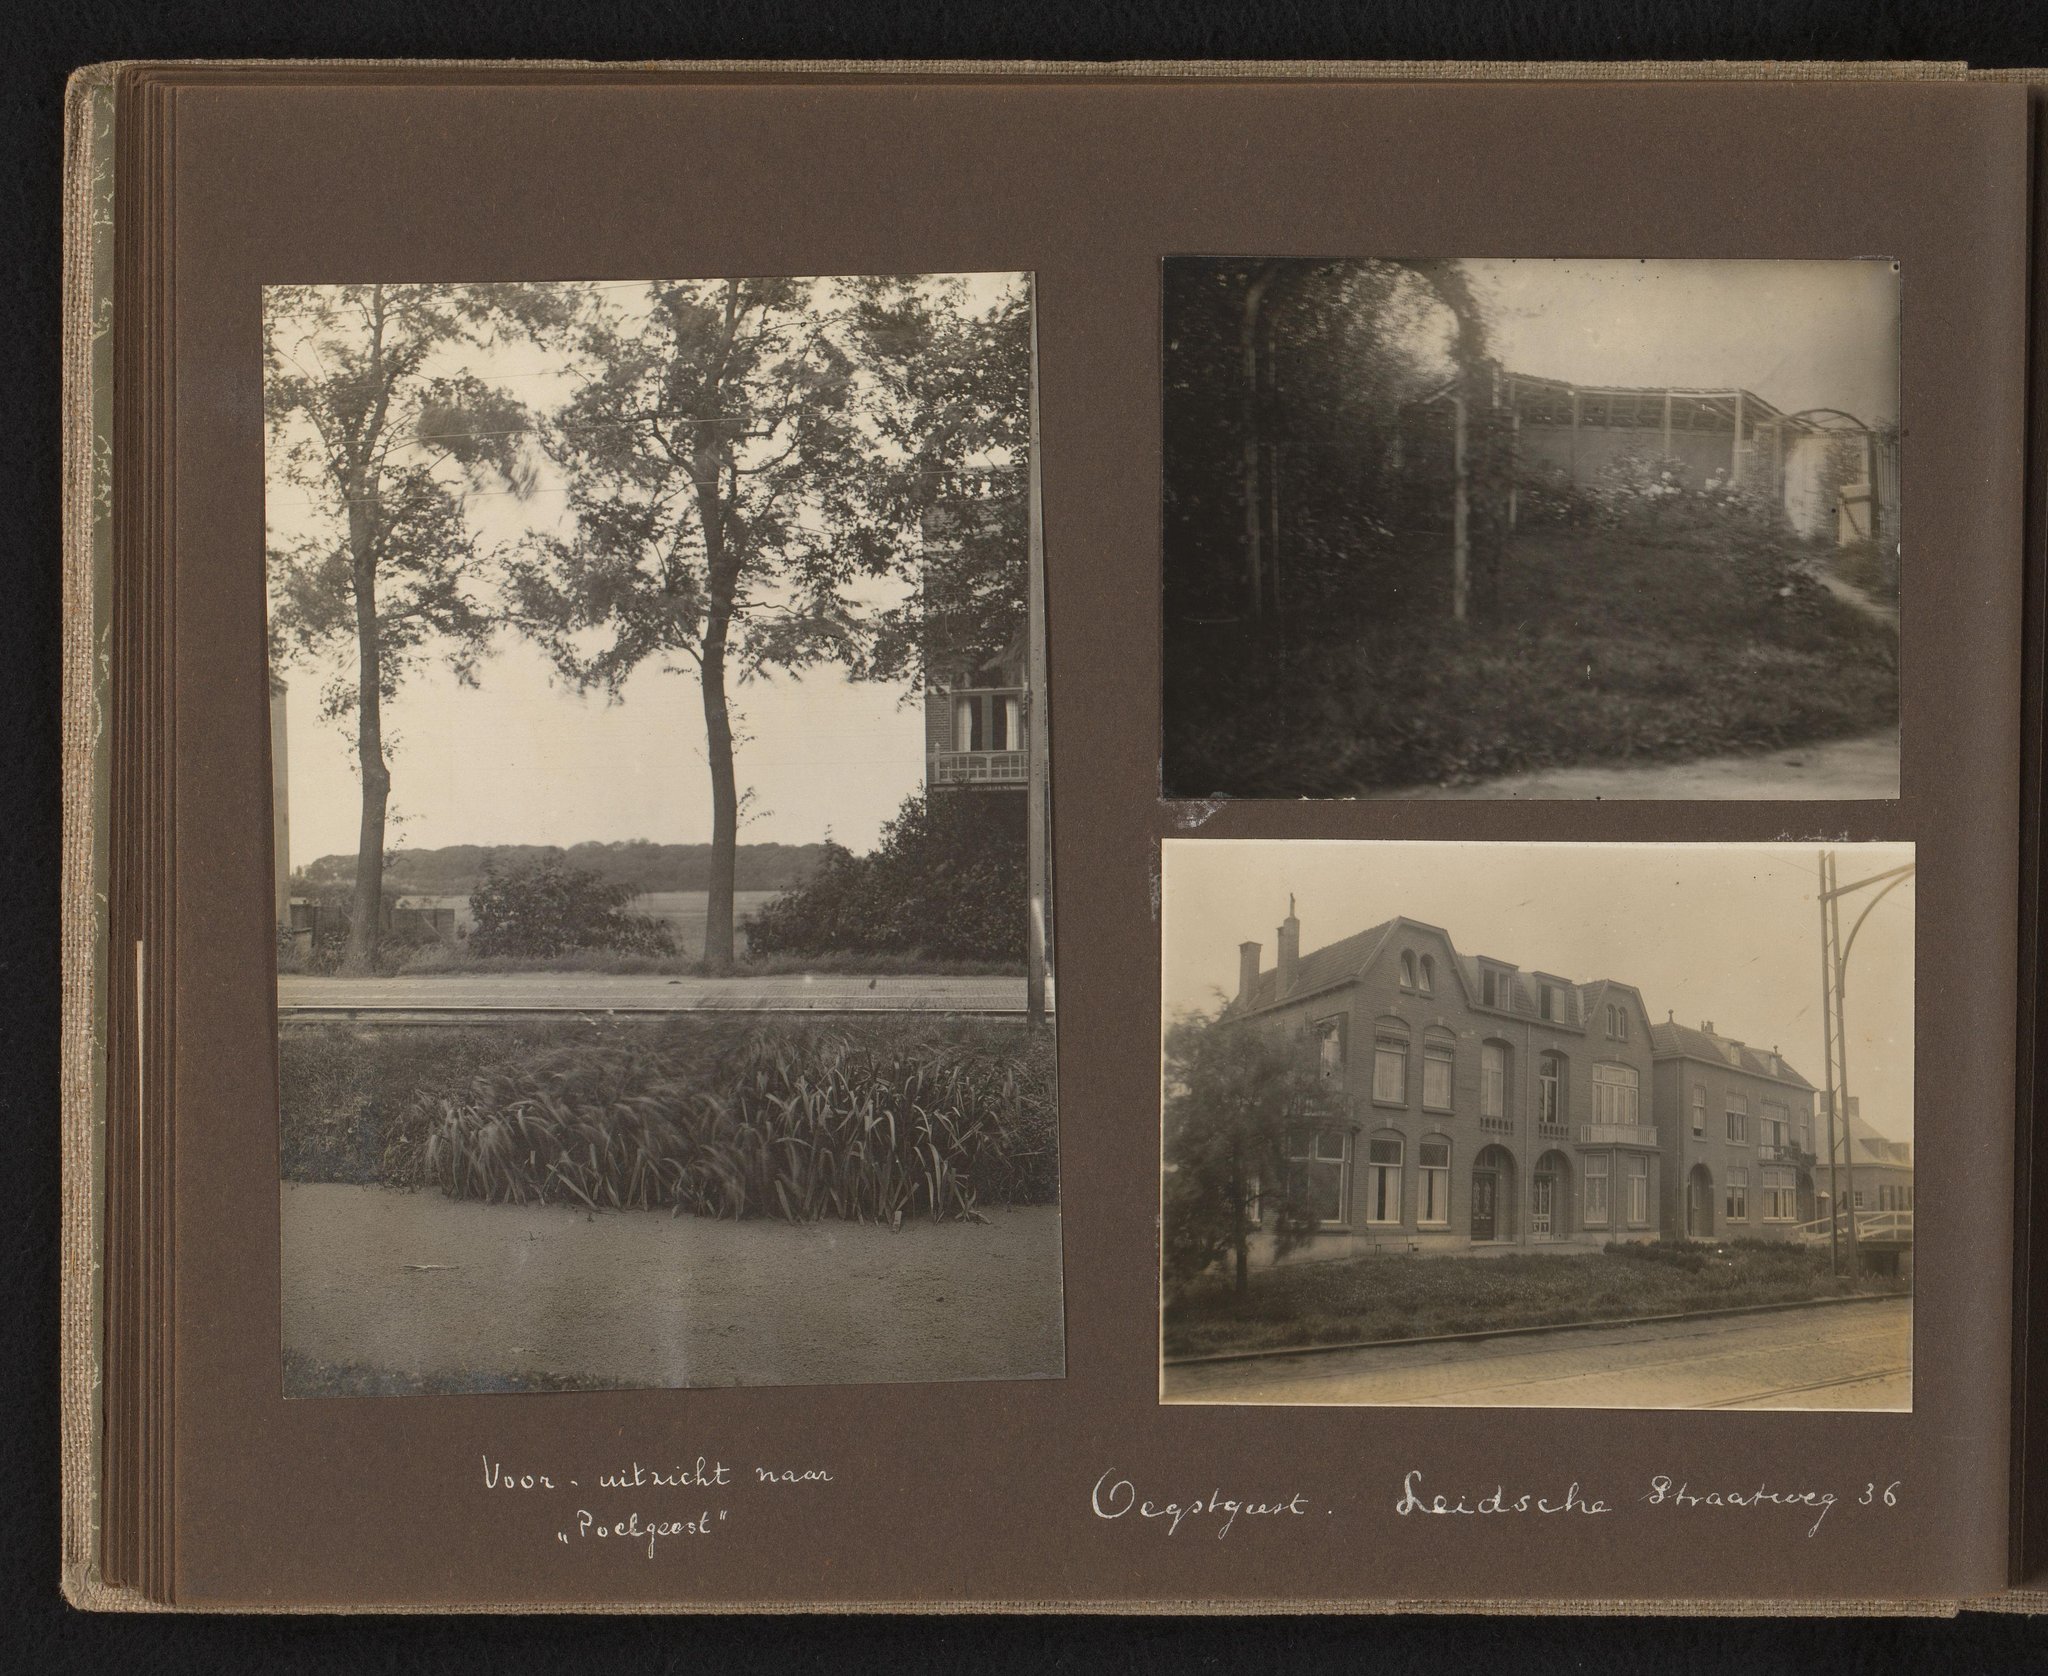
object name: photograph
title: Gezicht op de woning aan de Leidsestraatweg 36 te Oegstgeest en het uitzicht vanuit de woning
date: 1919-1930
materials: paper, cardboard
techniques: gelatin silver print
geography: oegstgeest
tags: façade (of house or building)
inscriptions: inscription: ‘Voor- uitzicht naar "Poelgeest"’, inscription: ‘Oegstgeest. Leidsche Straatweg 36’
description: Woning van Johanna (Hans) de Jong en Frederik (Frits) Stokhuyzen op de Leidsestraatweg 36 te Oegstgeest. Deze foto maakt deel uit van een album.